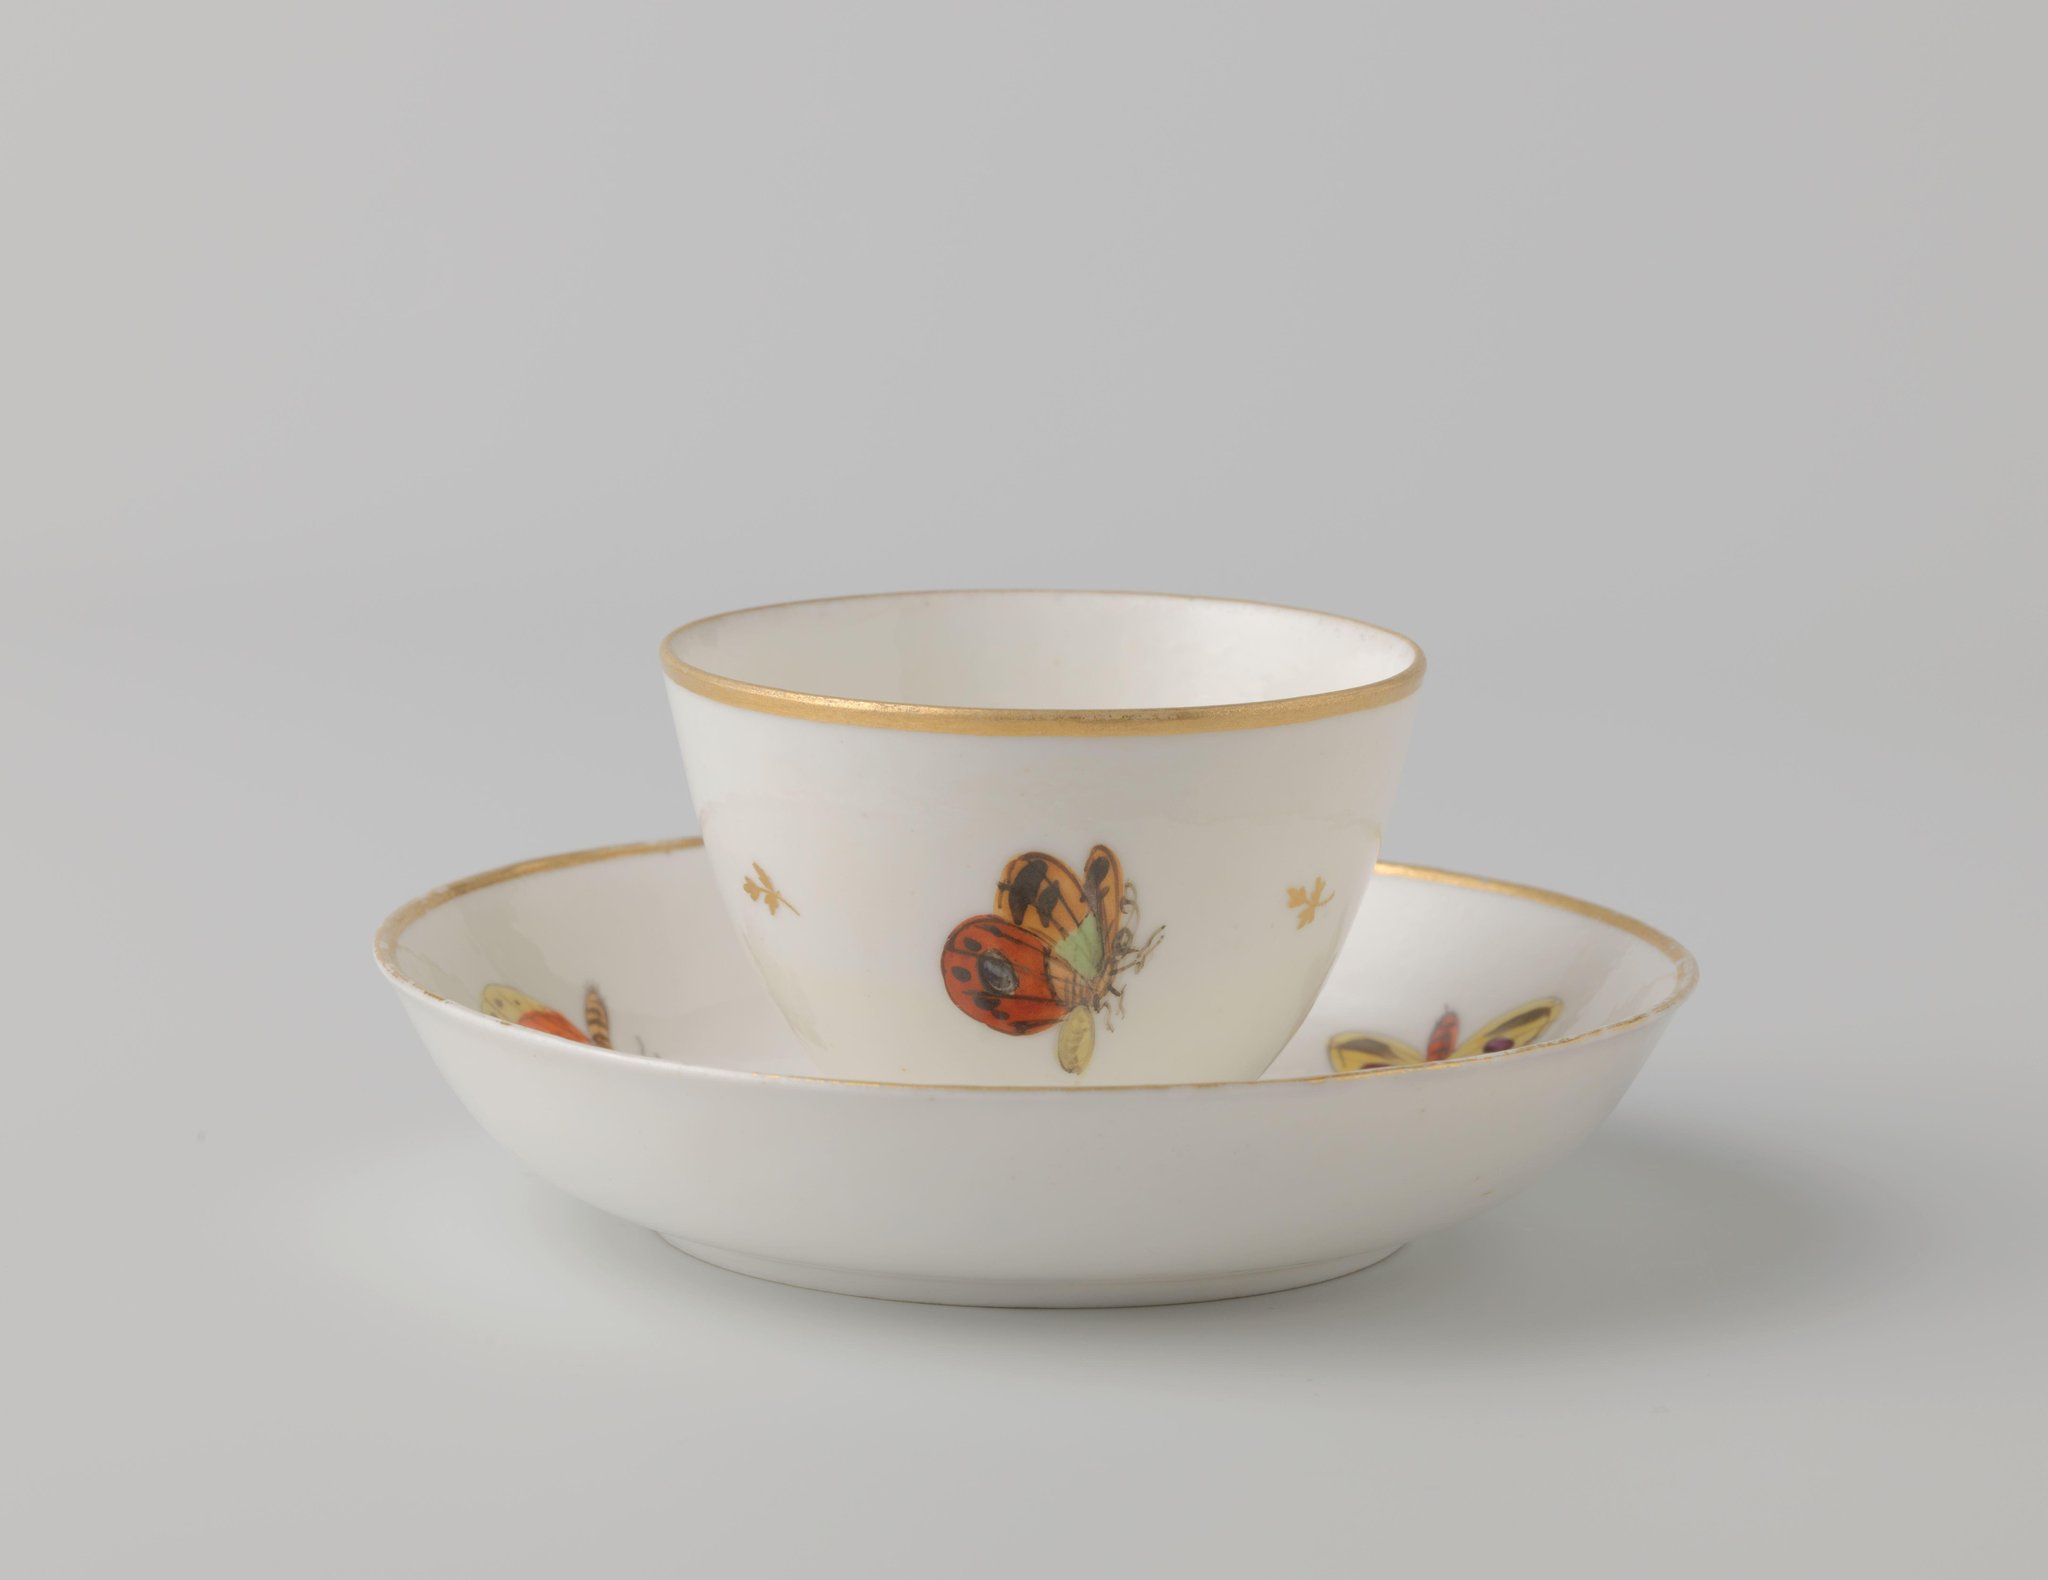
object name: platter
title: Schotel beschilderd met vlinders en libellen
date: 1784-1809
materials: porcelain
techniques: painted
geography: ouder-amstel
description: Schotel veelkleurig beschilderd met vlinders en libellen. Gemerkt: Amstel.